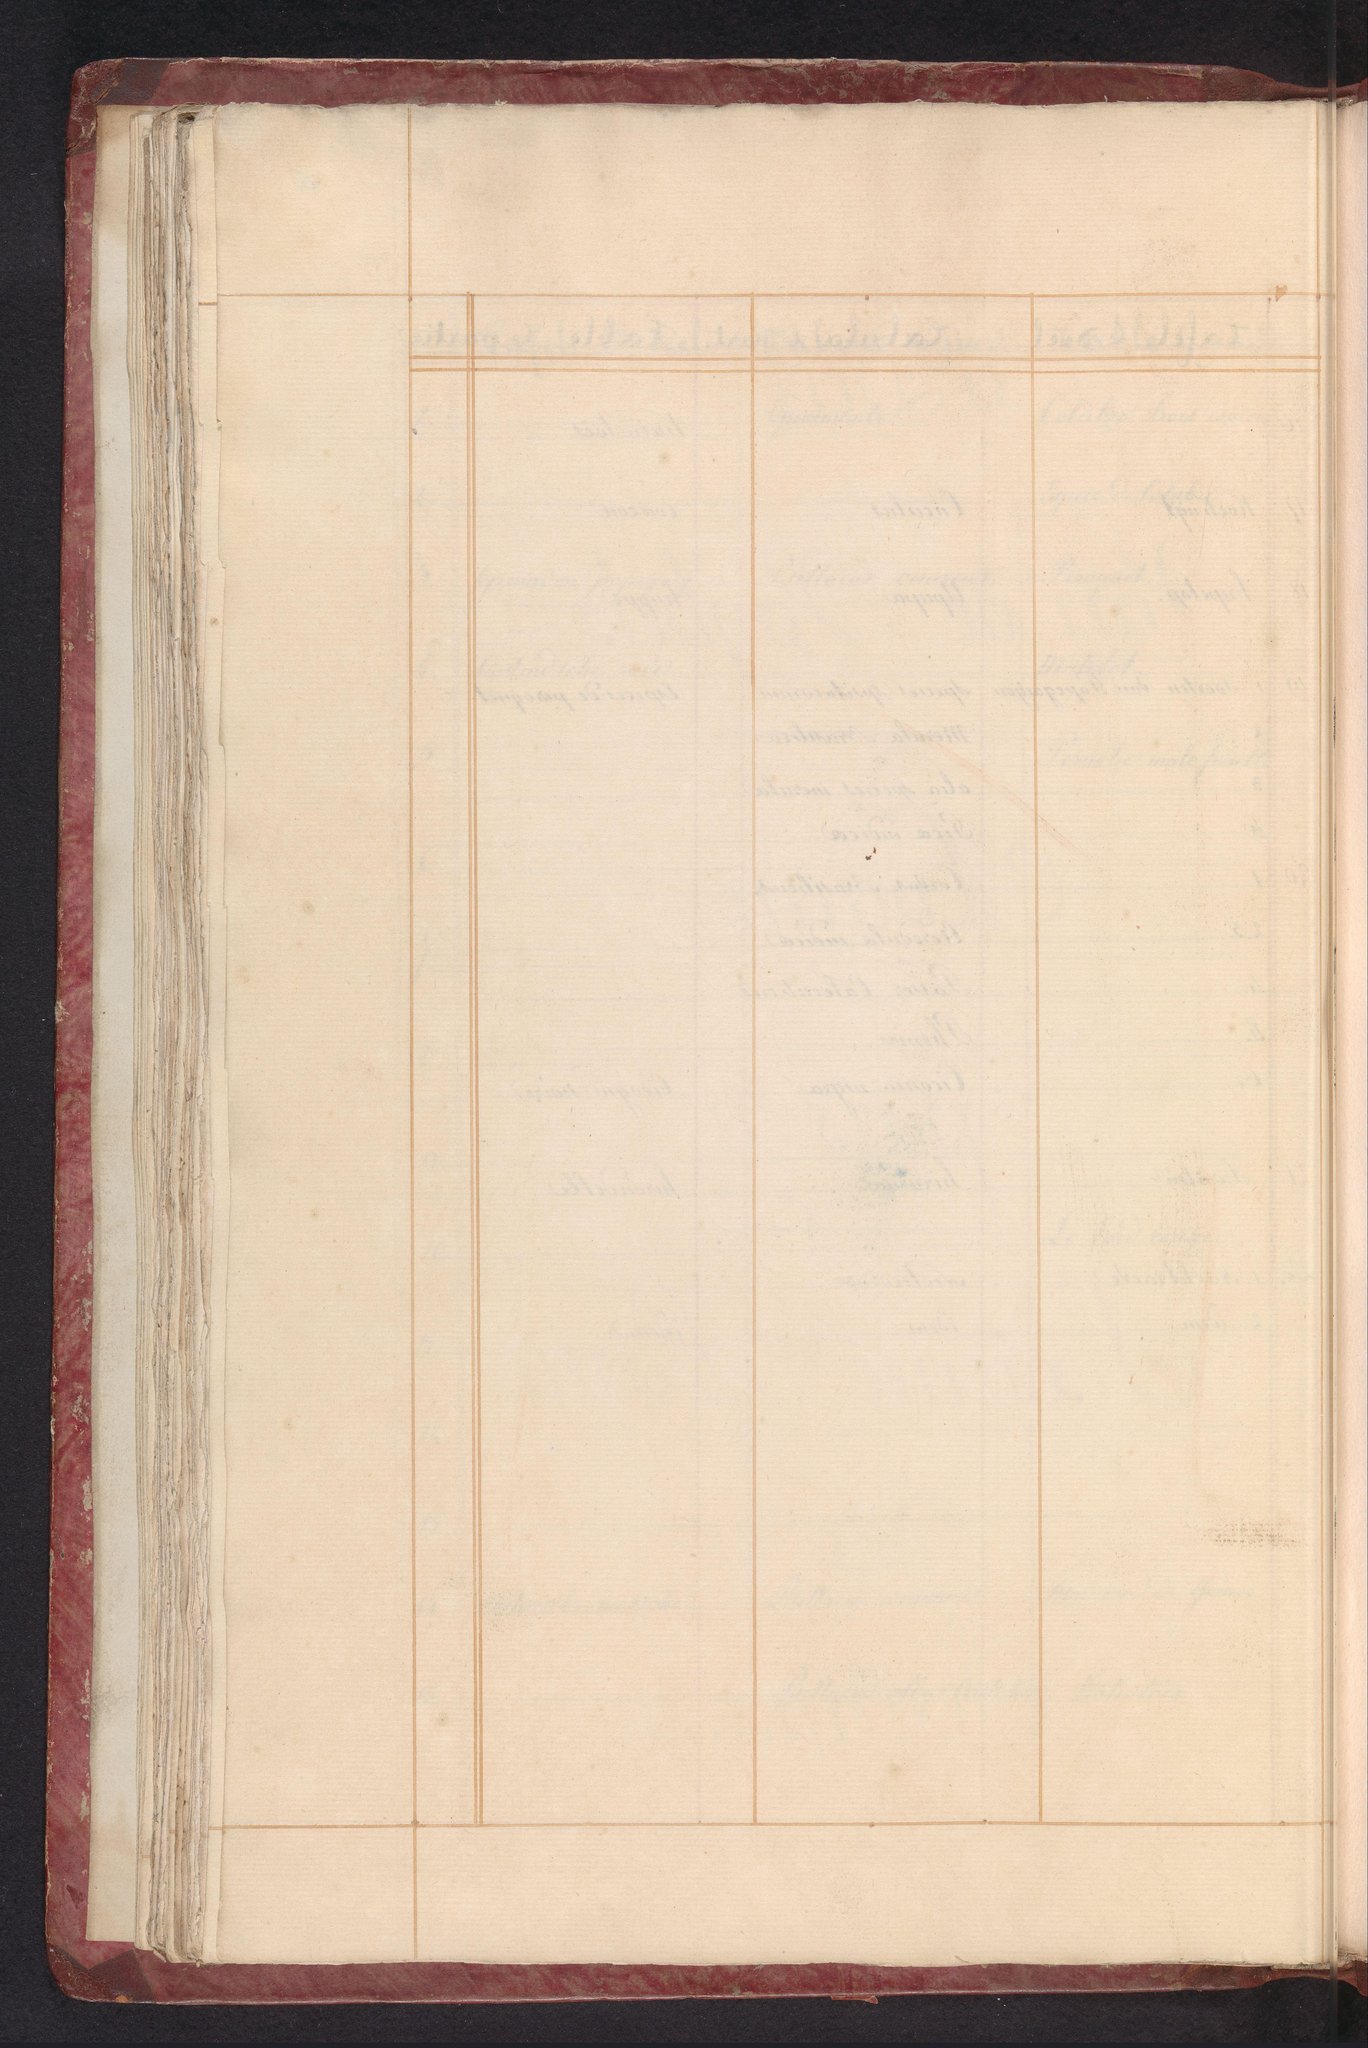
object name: manuscript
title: Oningevuld schema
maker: joseph van huerne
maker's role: kunstliefhebber, mecenas, verzamelaar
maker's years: 1752-1844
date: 1809-1814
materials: ink, paper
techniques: handwriting, pen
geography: bruges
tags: handwriting, written text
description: Oningevuld schema met drie kolommen. Onderdeel van het tweede album met tekeningen van vogels. Vierde van twaalf albums met tekeningen van dieren, vogels en planten bekend rond 1600, gemaakt in opdracht van keizer Rudolf II. Met toelichting in Nederlands, Latijn en Frans.